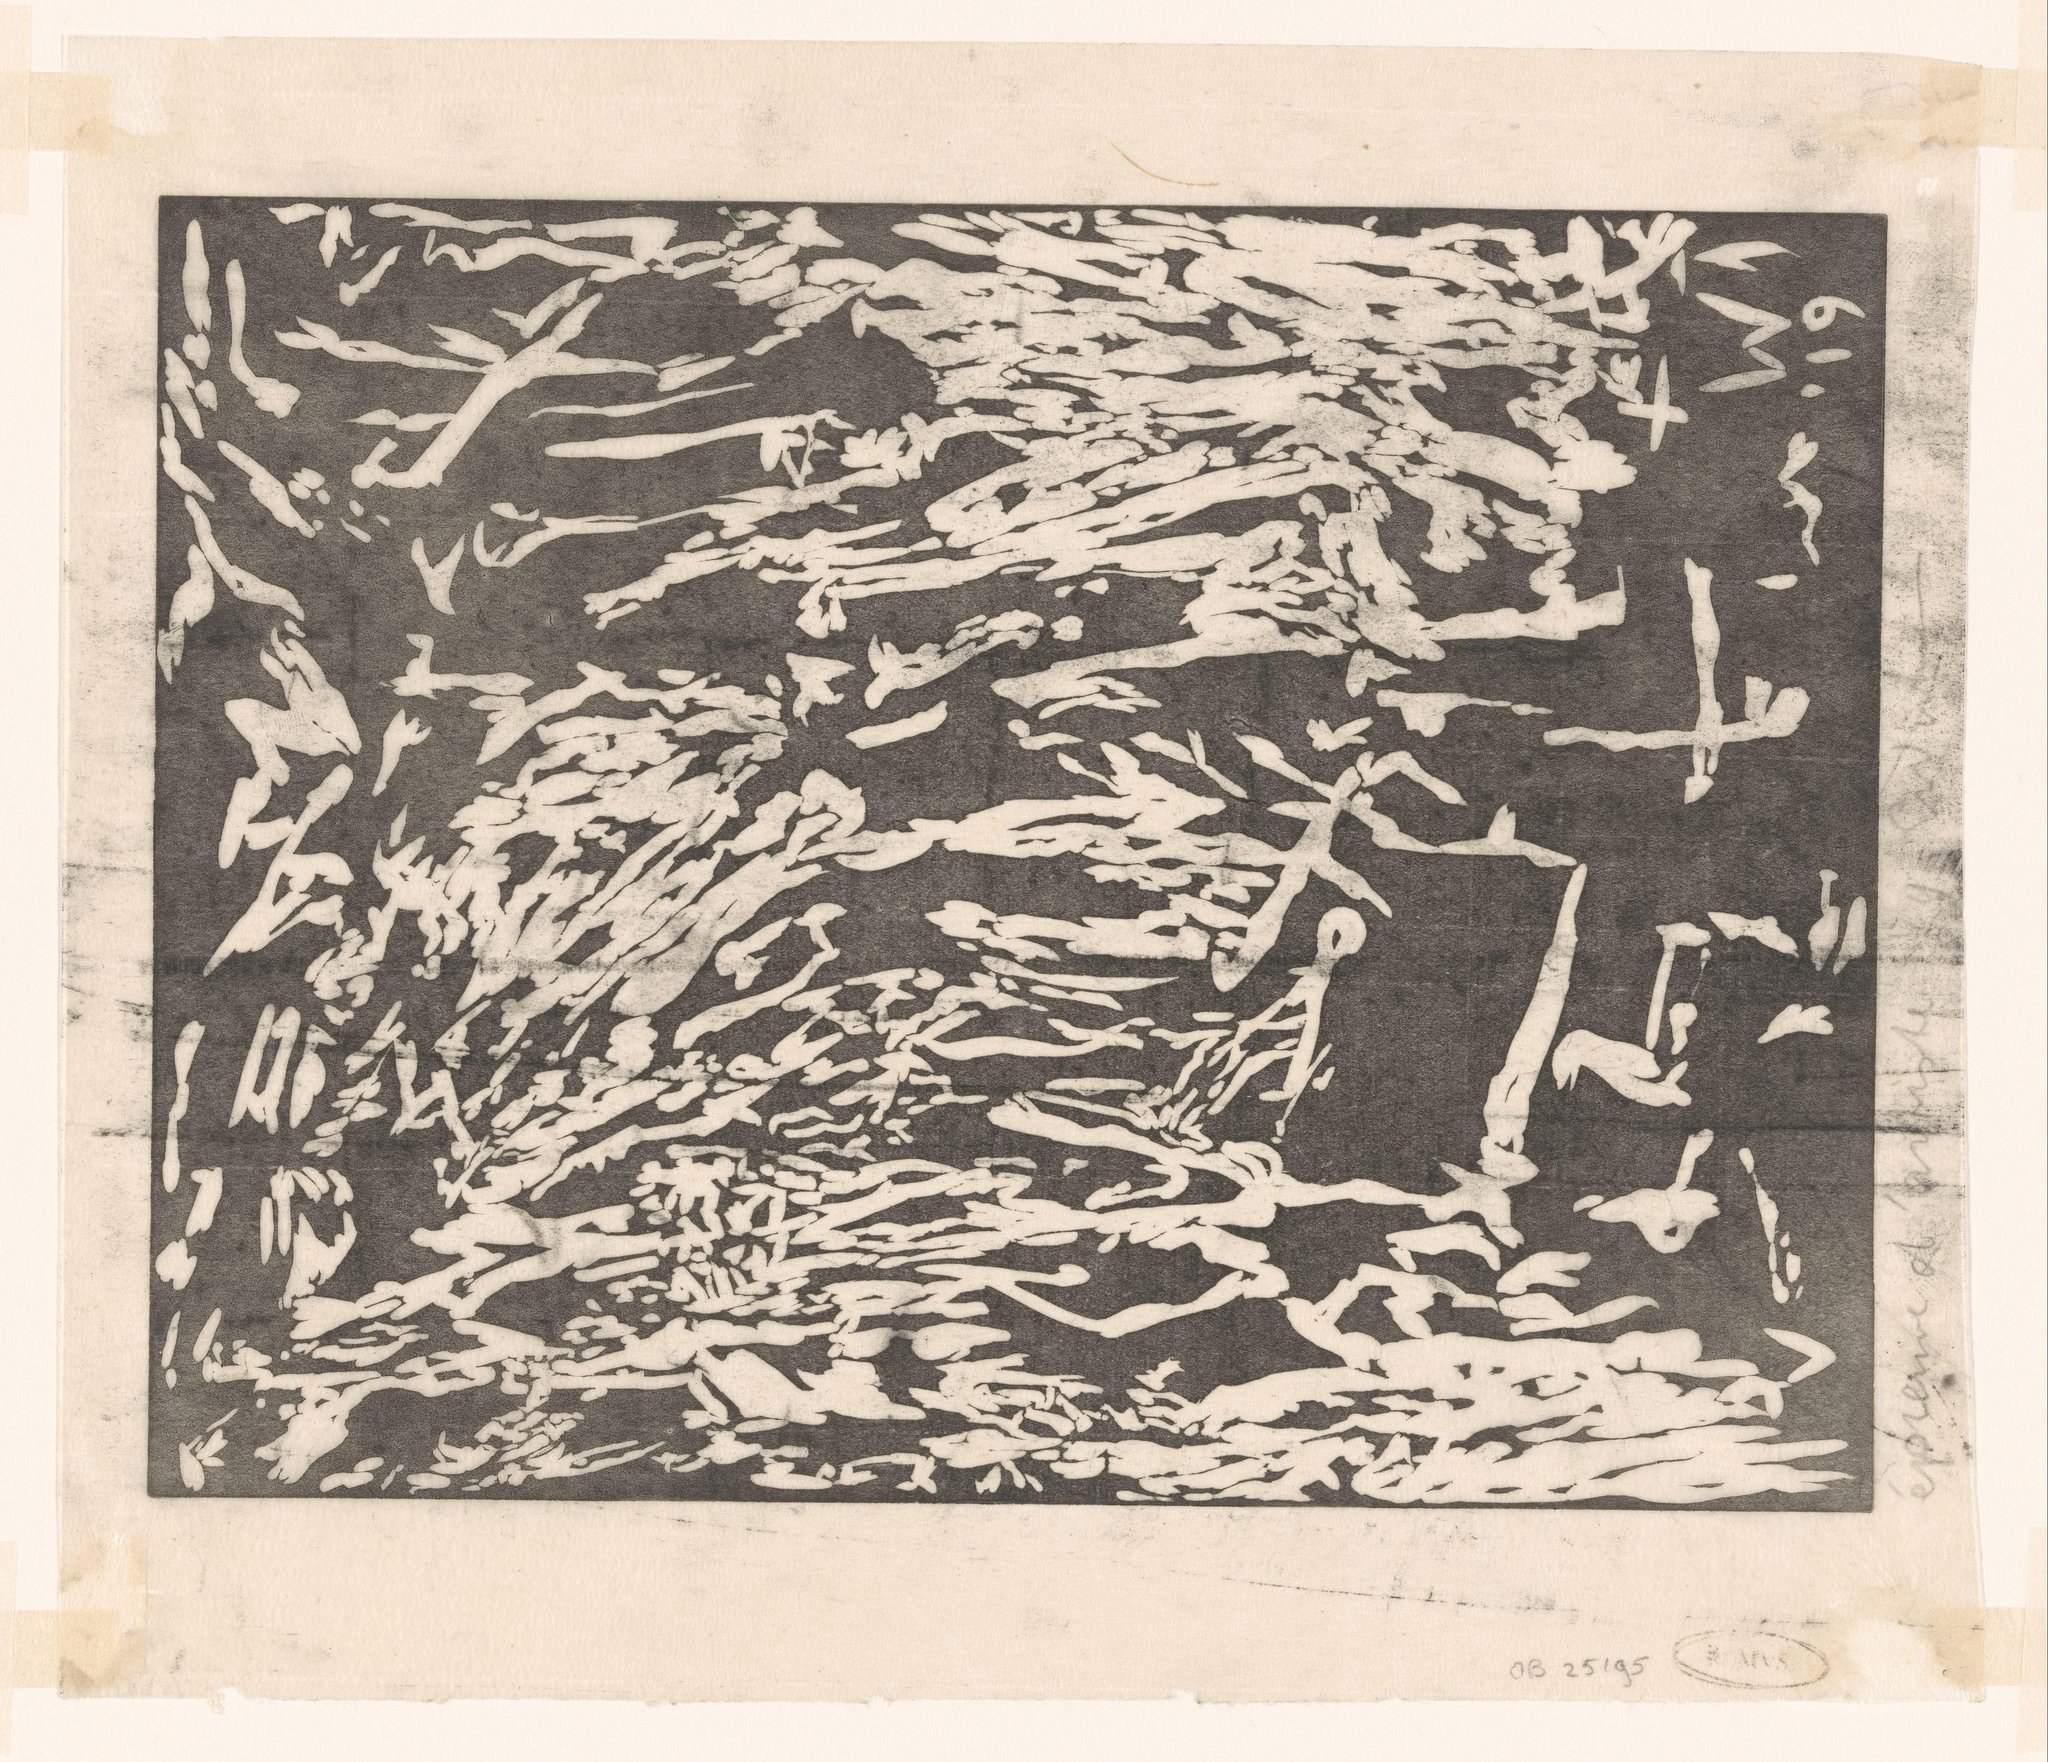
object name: print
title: Abstracte compositie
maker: erich wichmann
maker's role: print maker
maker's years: 1890-1929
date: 1919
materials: paper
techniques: woodcut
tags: abstract, non-representational art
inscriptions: collector's mark: Lugt 2228